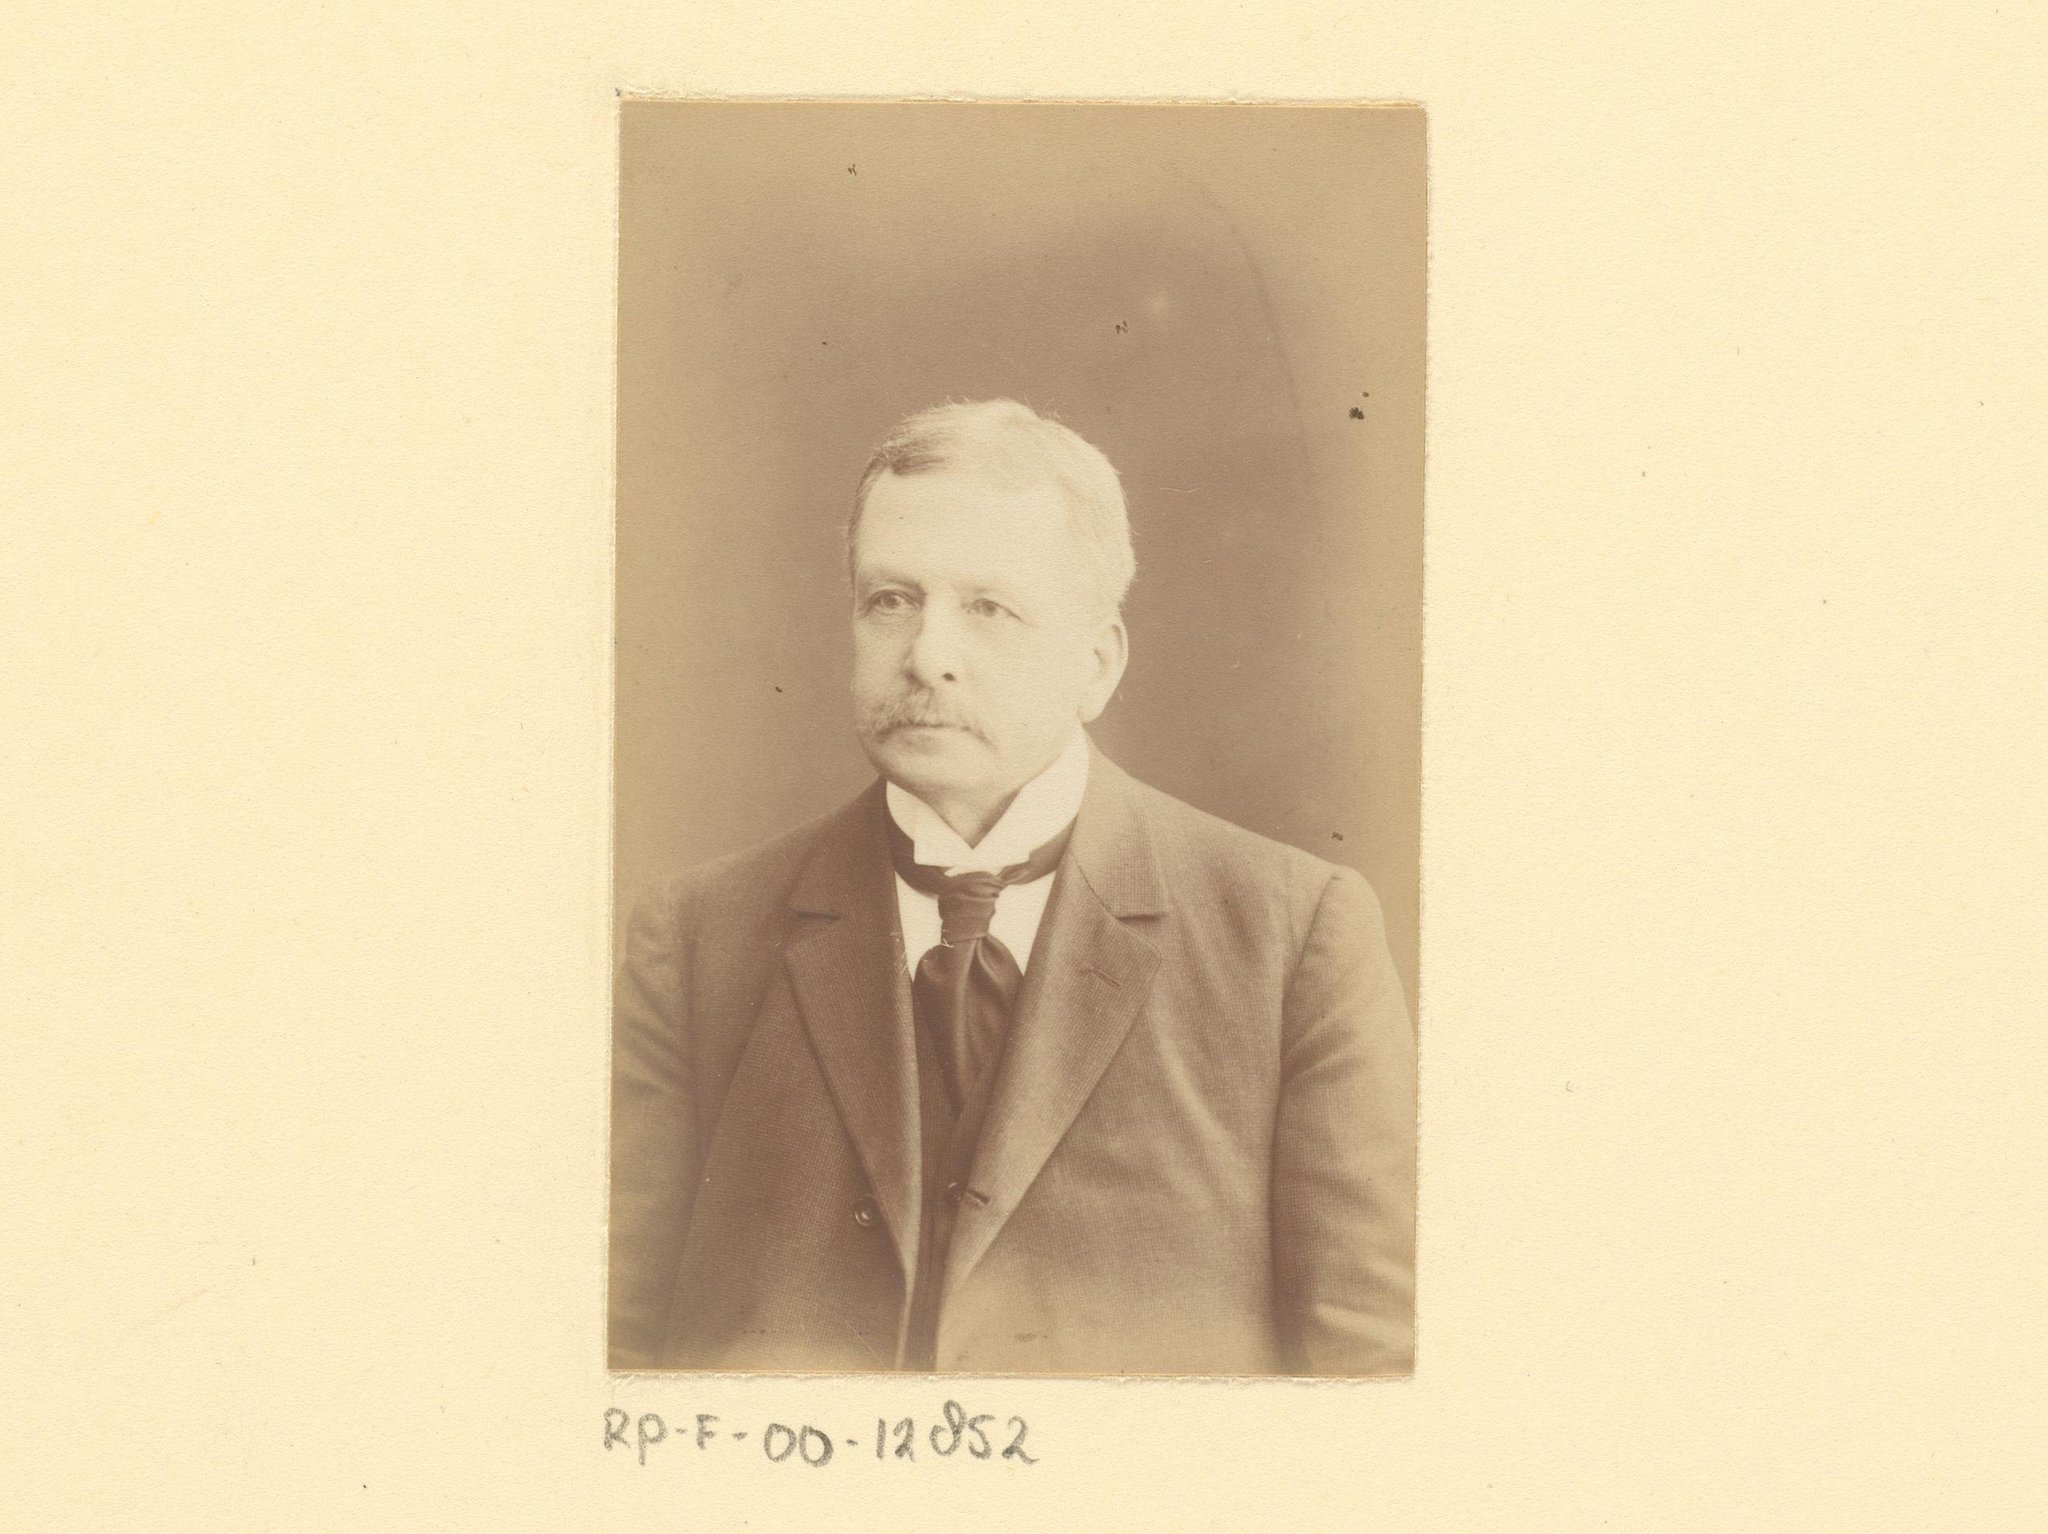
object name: photograph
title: Portret van S. Hannema, secretaris-generaal van het Ministerie van Buitenlandse Zaken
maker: Anonymous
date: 1880-1900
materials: paper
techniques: albumen print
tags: historical persons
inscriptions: inscription: ‘Mr Sj. Hannema/ Sec. Gen. v. B. Zaken’